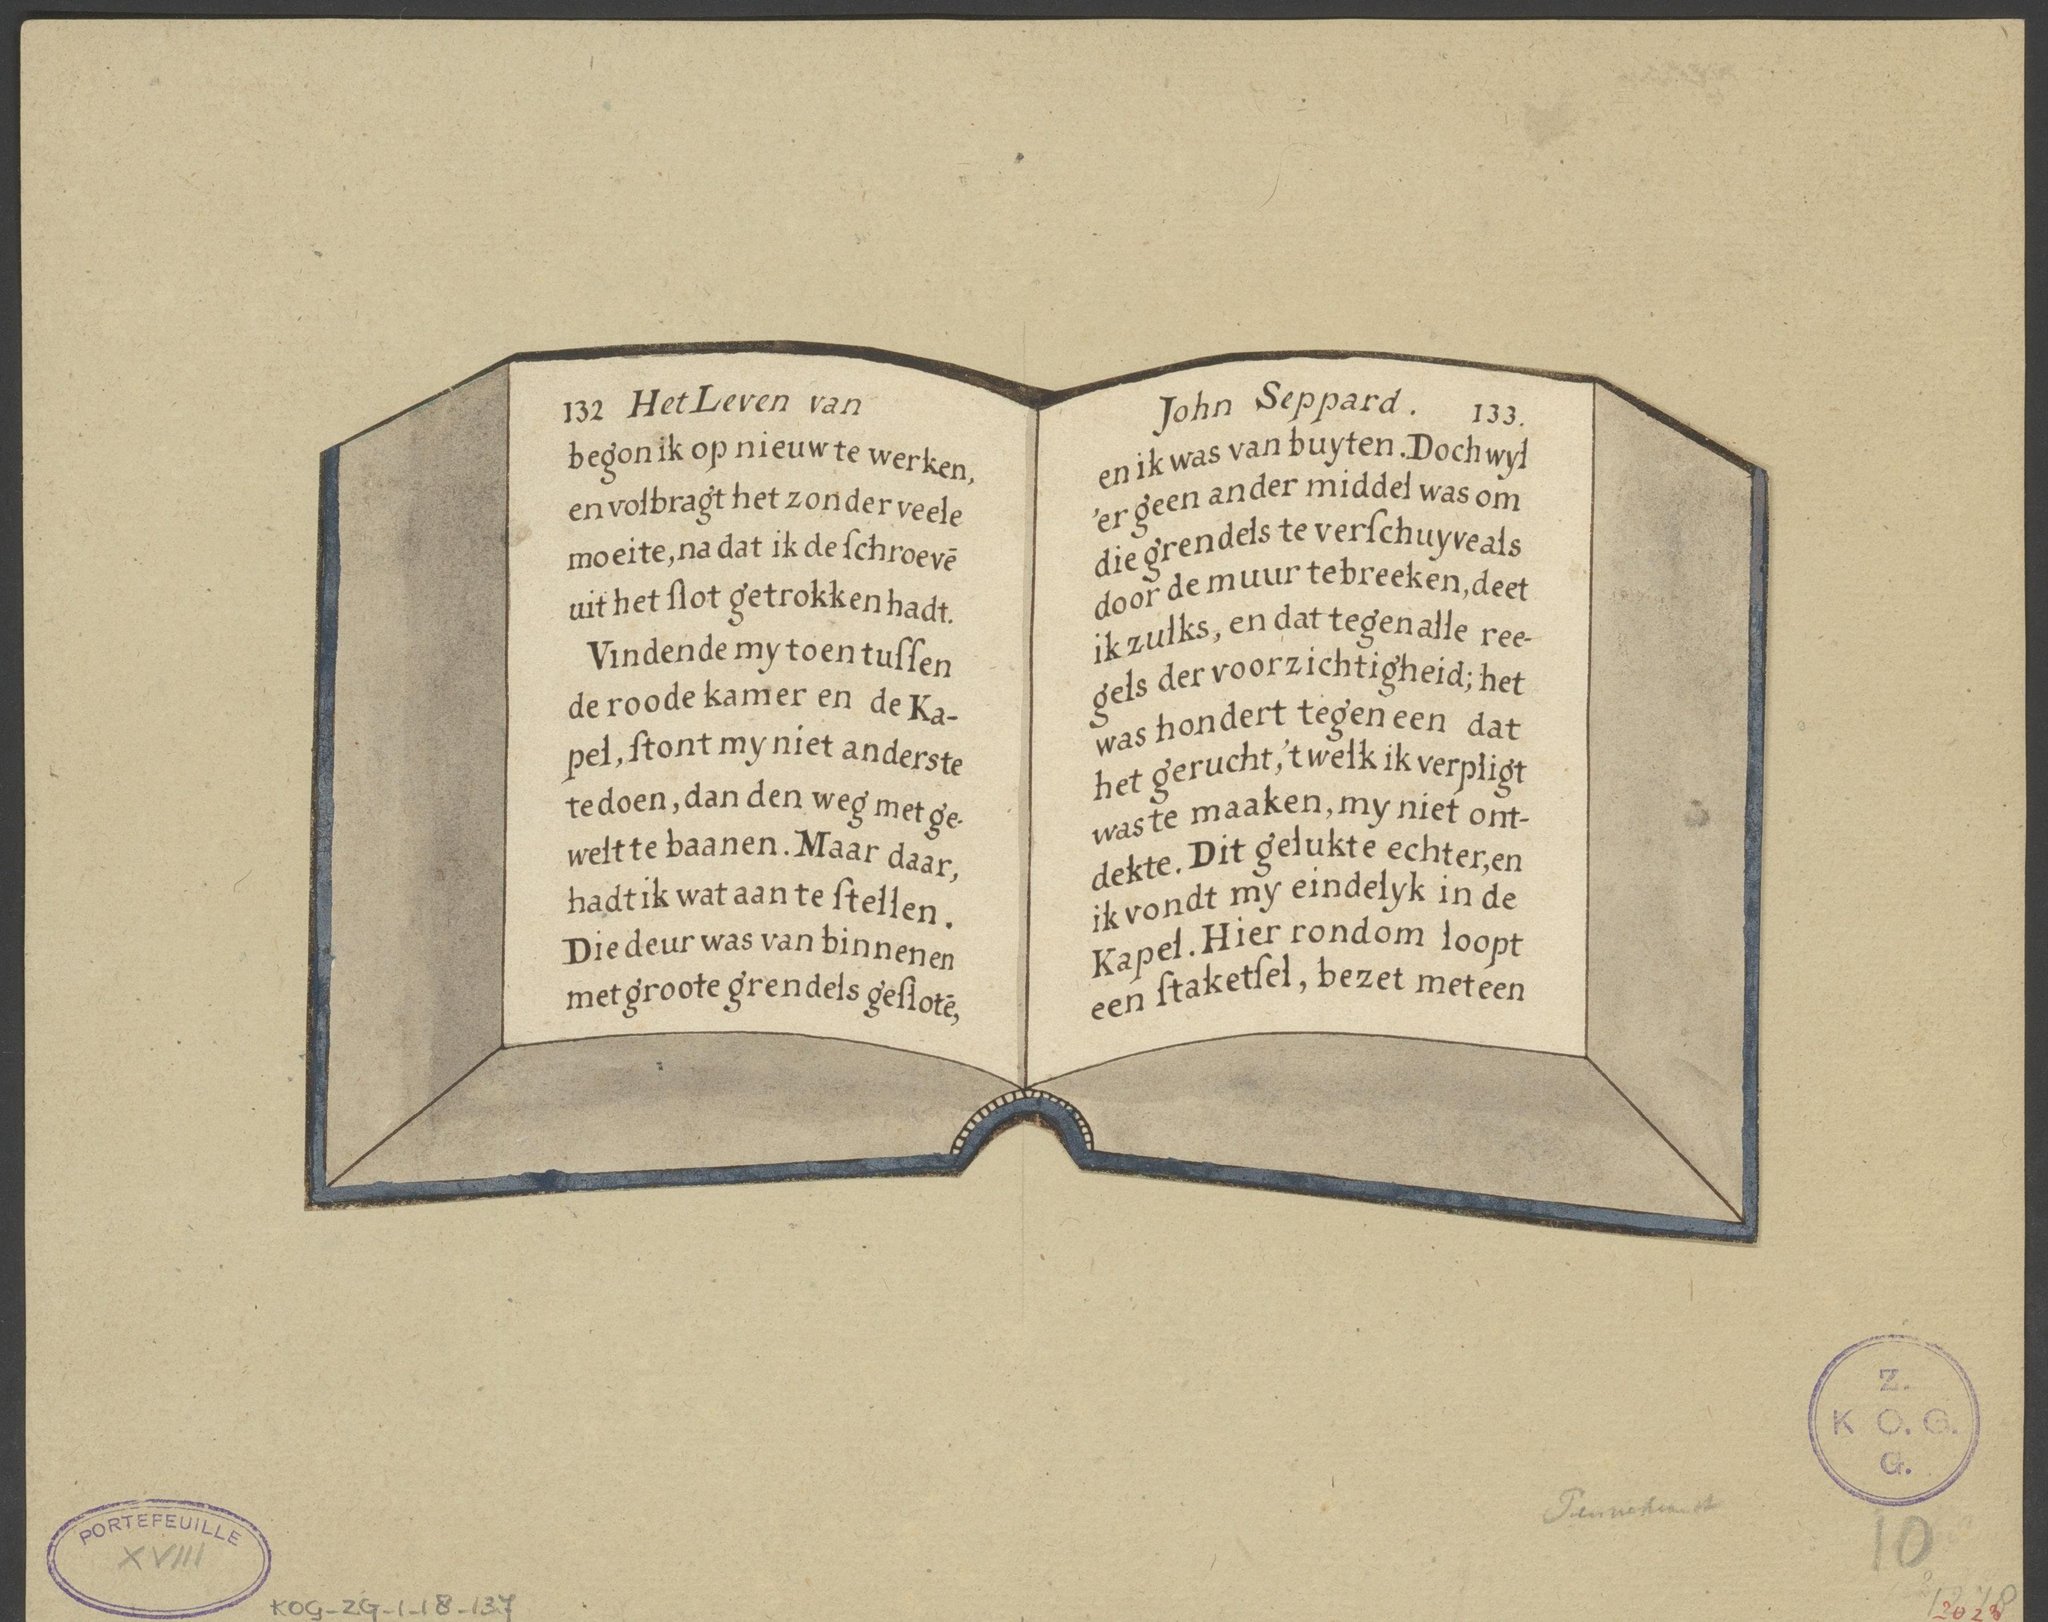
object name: drawing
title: Opengeslagen boek met twee pagina's uit Het leven van John Sheppard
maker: Anonymous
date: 1800-1849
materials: ink, paper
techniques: brush, pen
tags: book - mm - book open, calligraphy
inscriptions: stamp, collector's mark: Lugt 1641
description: Onderwerpsrubrieken binnen de Atlas Zeden en Gewoonten: Schoone kunsten, Pennekunst.